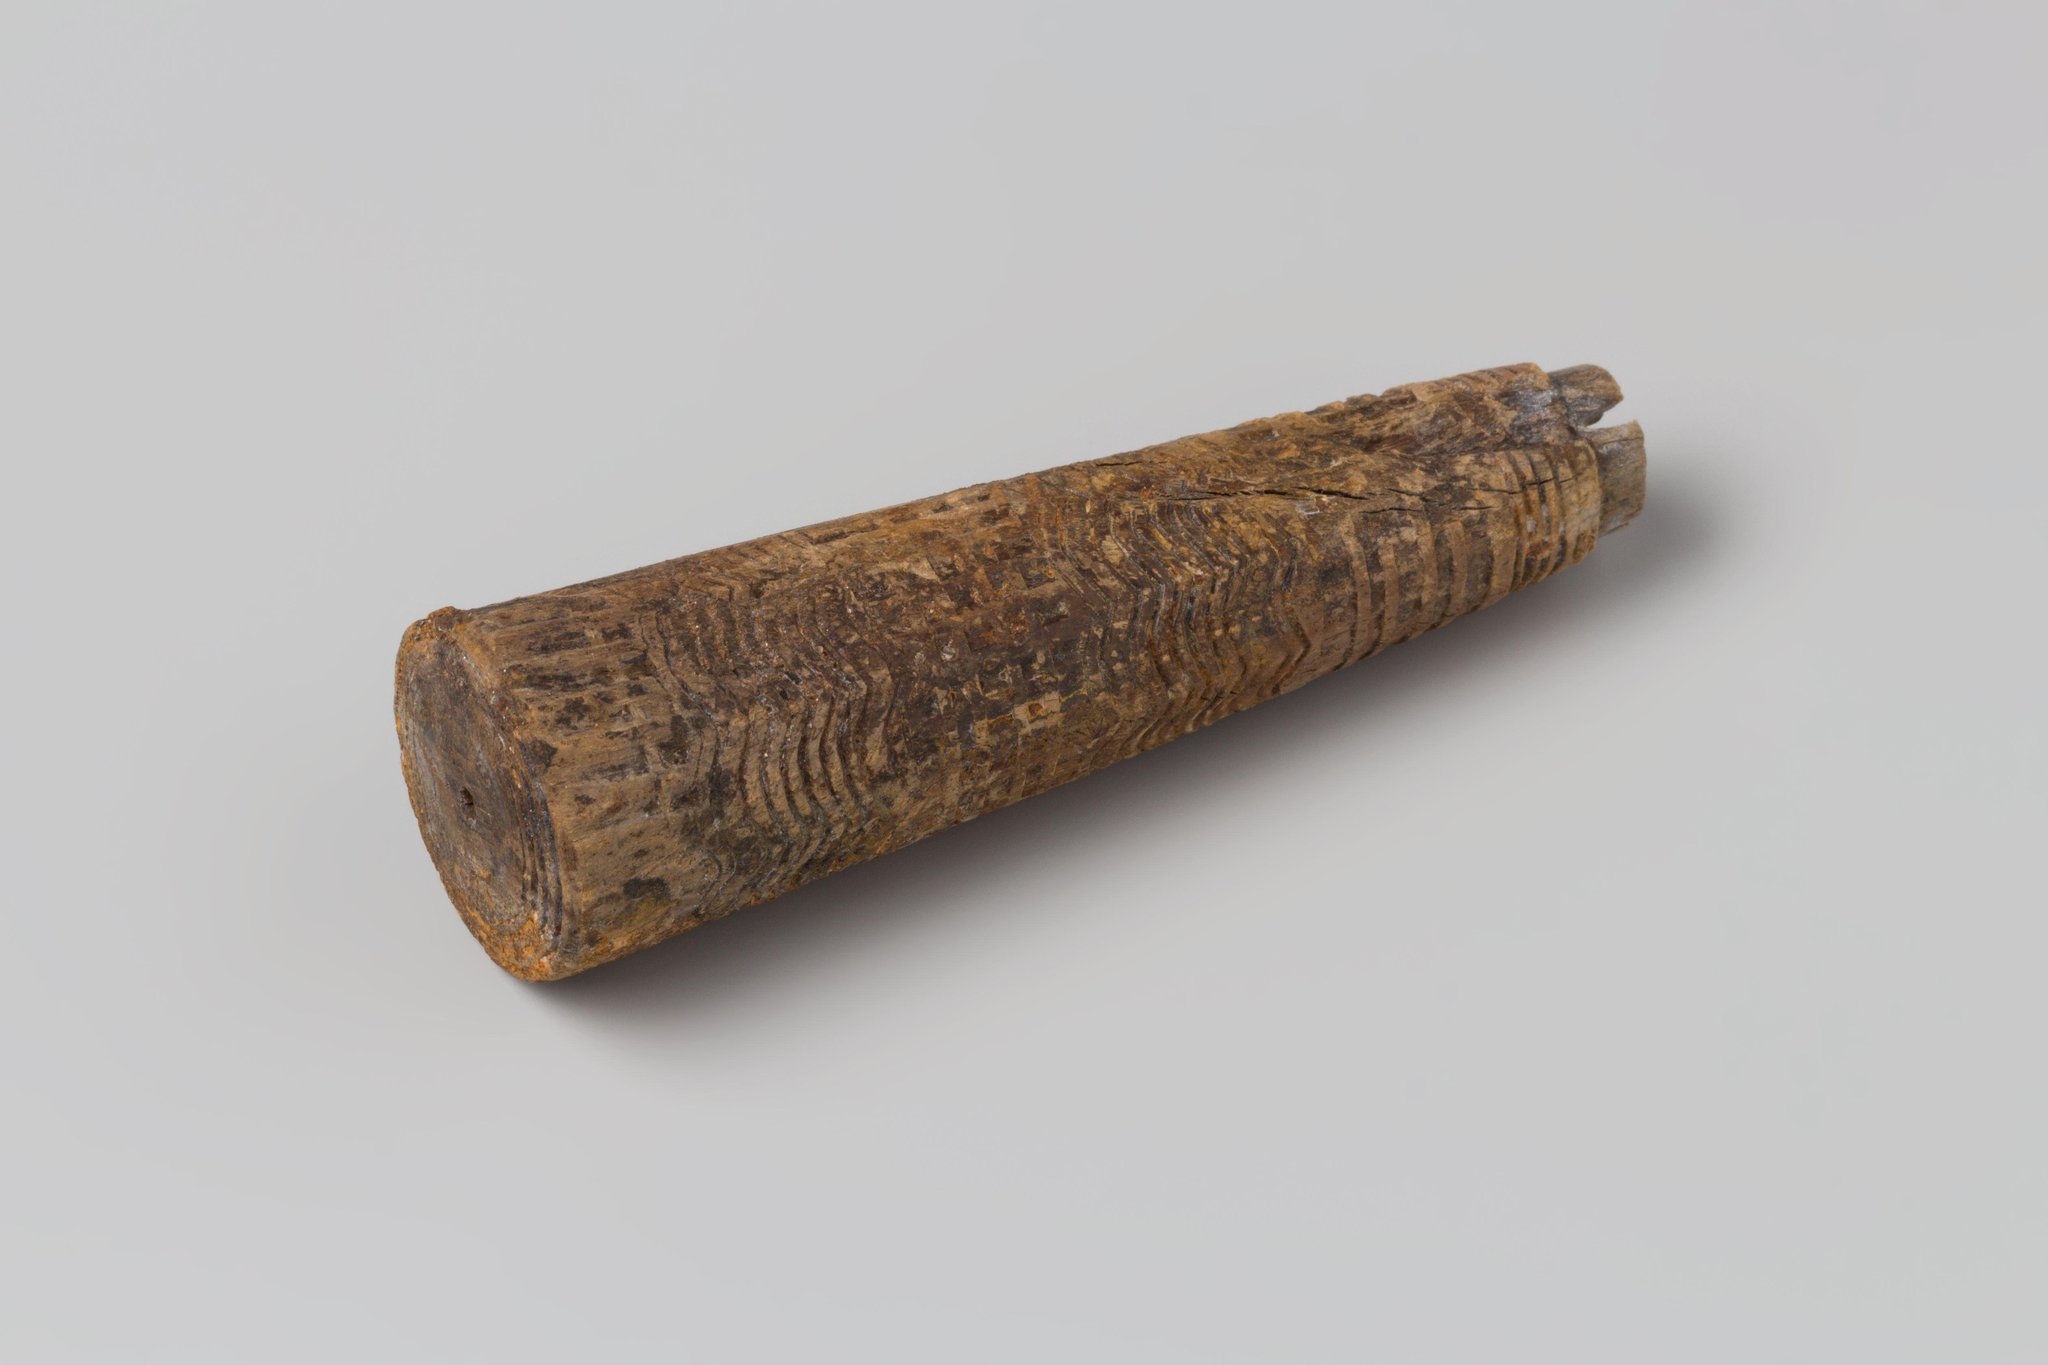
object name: knife handle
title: Messenheft uit het wrak van de Oost-Indiëvaarder Hollandia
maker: Anonymous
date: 1700-1743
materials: wood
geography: netherlands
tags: verenigde oostindische compagnie, hollandia (schip), annet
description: Knife, handle, cylindrical: tapering; id. NG 1979-403H.